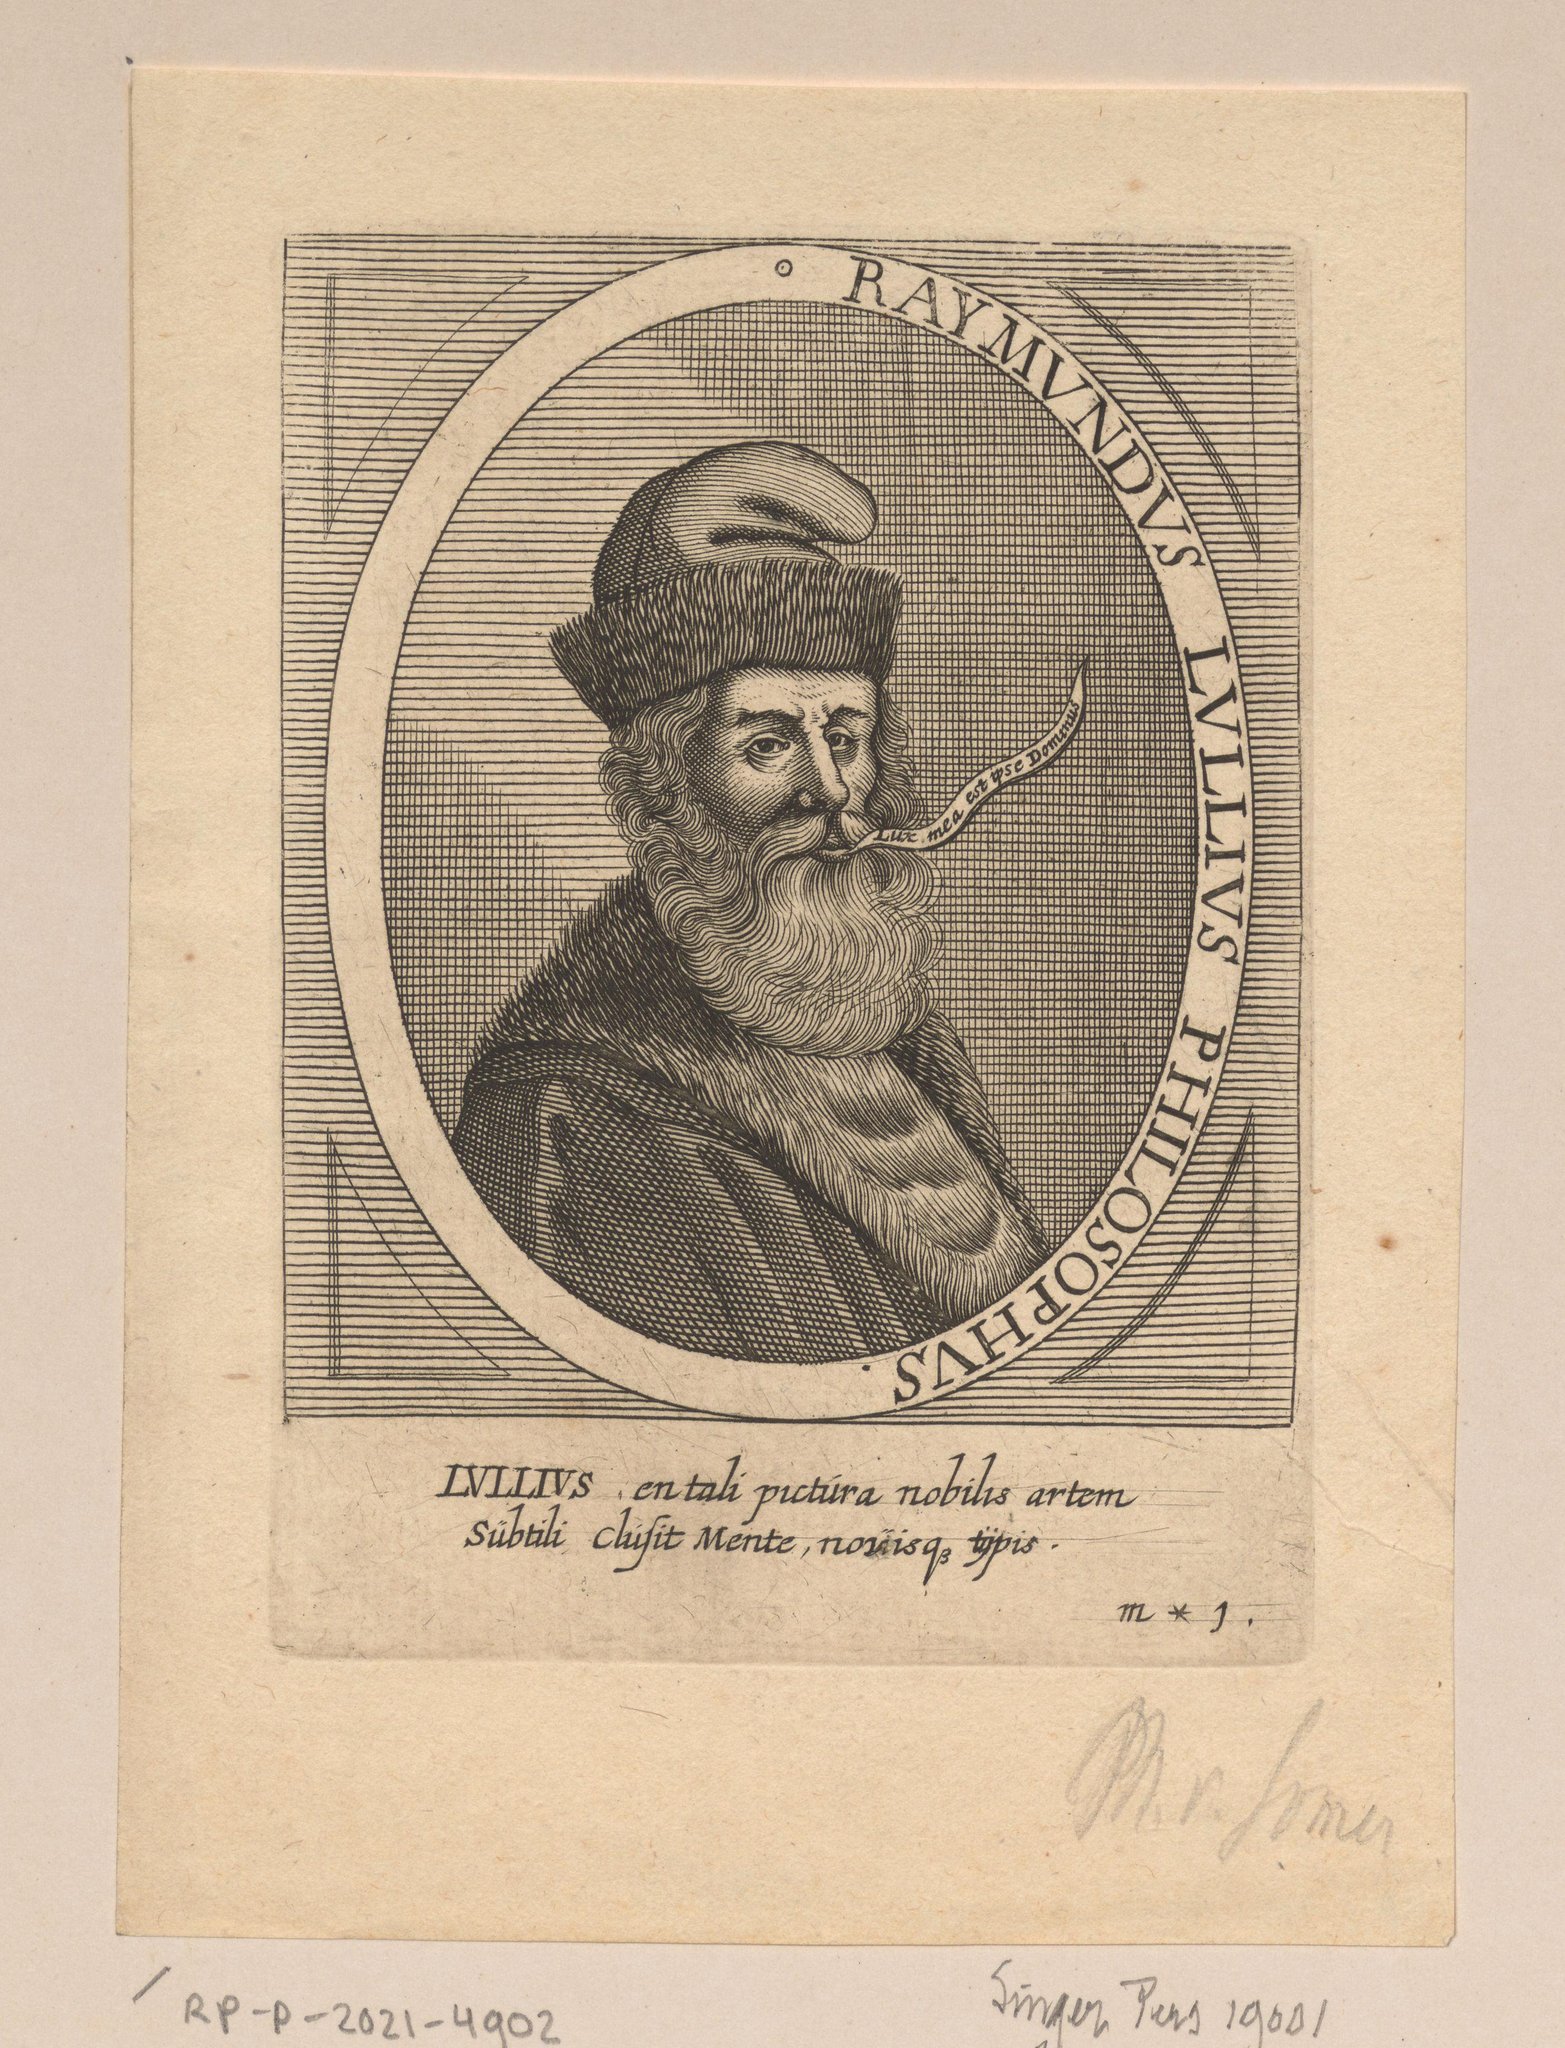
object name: print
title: Bibliotheca chalcographica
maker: Anonymous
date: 1650-1654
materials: paper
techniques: engraving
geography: germany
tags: historical persons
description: Prent waarschijnlijk uit een deel van: Bibliotheca chalcographica (...). Frankfurt am Main: Johannes Ammon, 1650-1654.